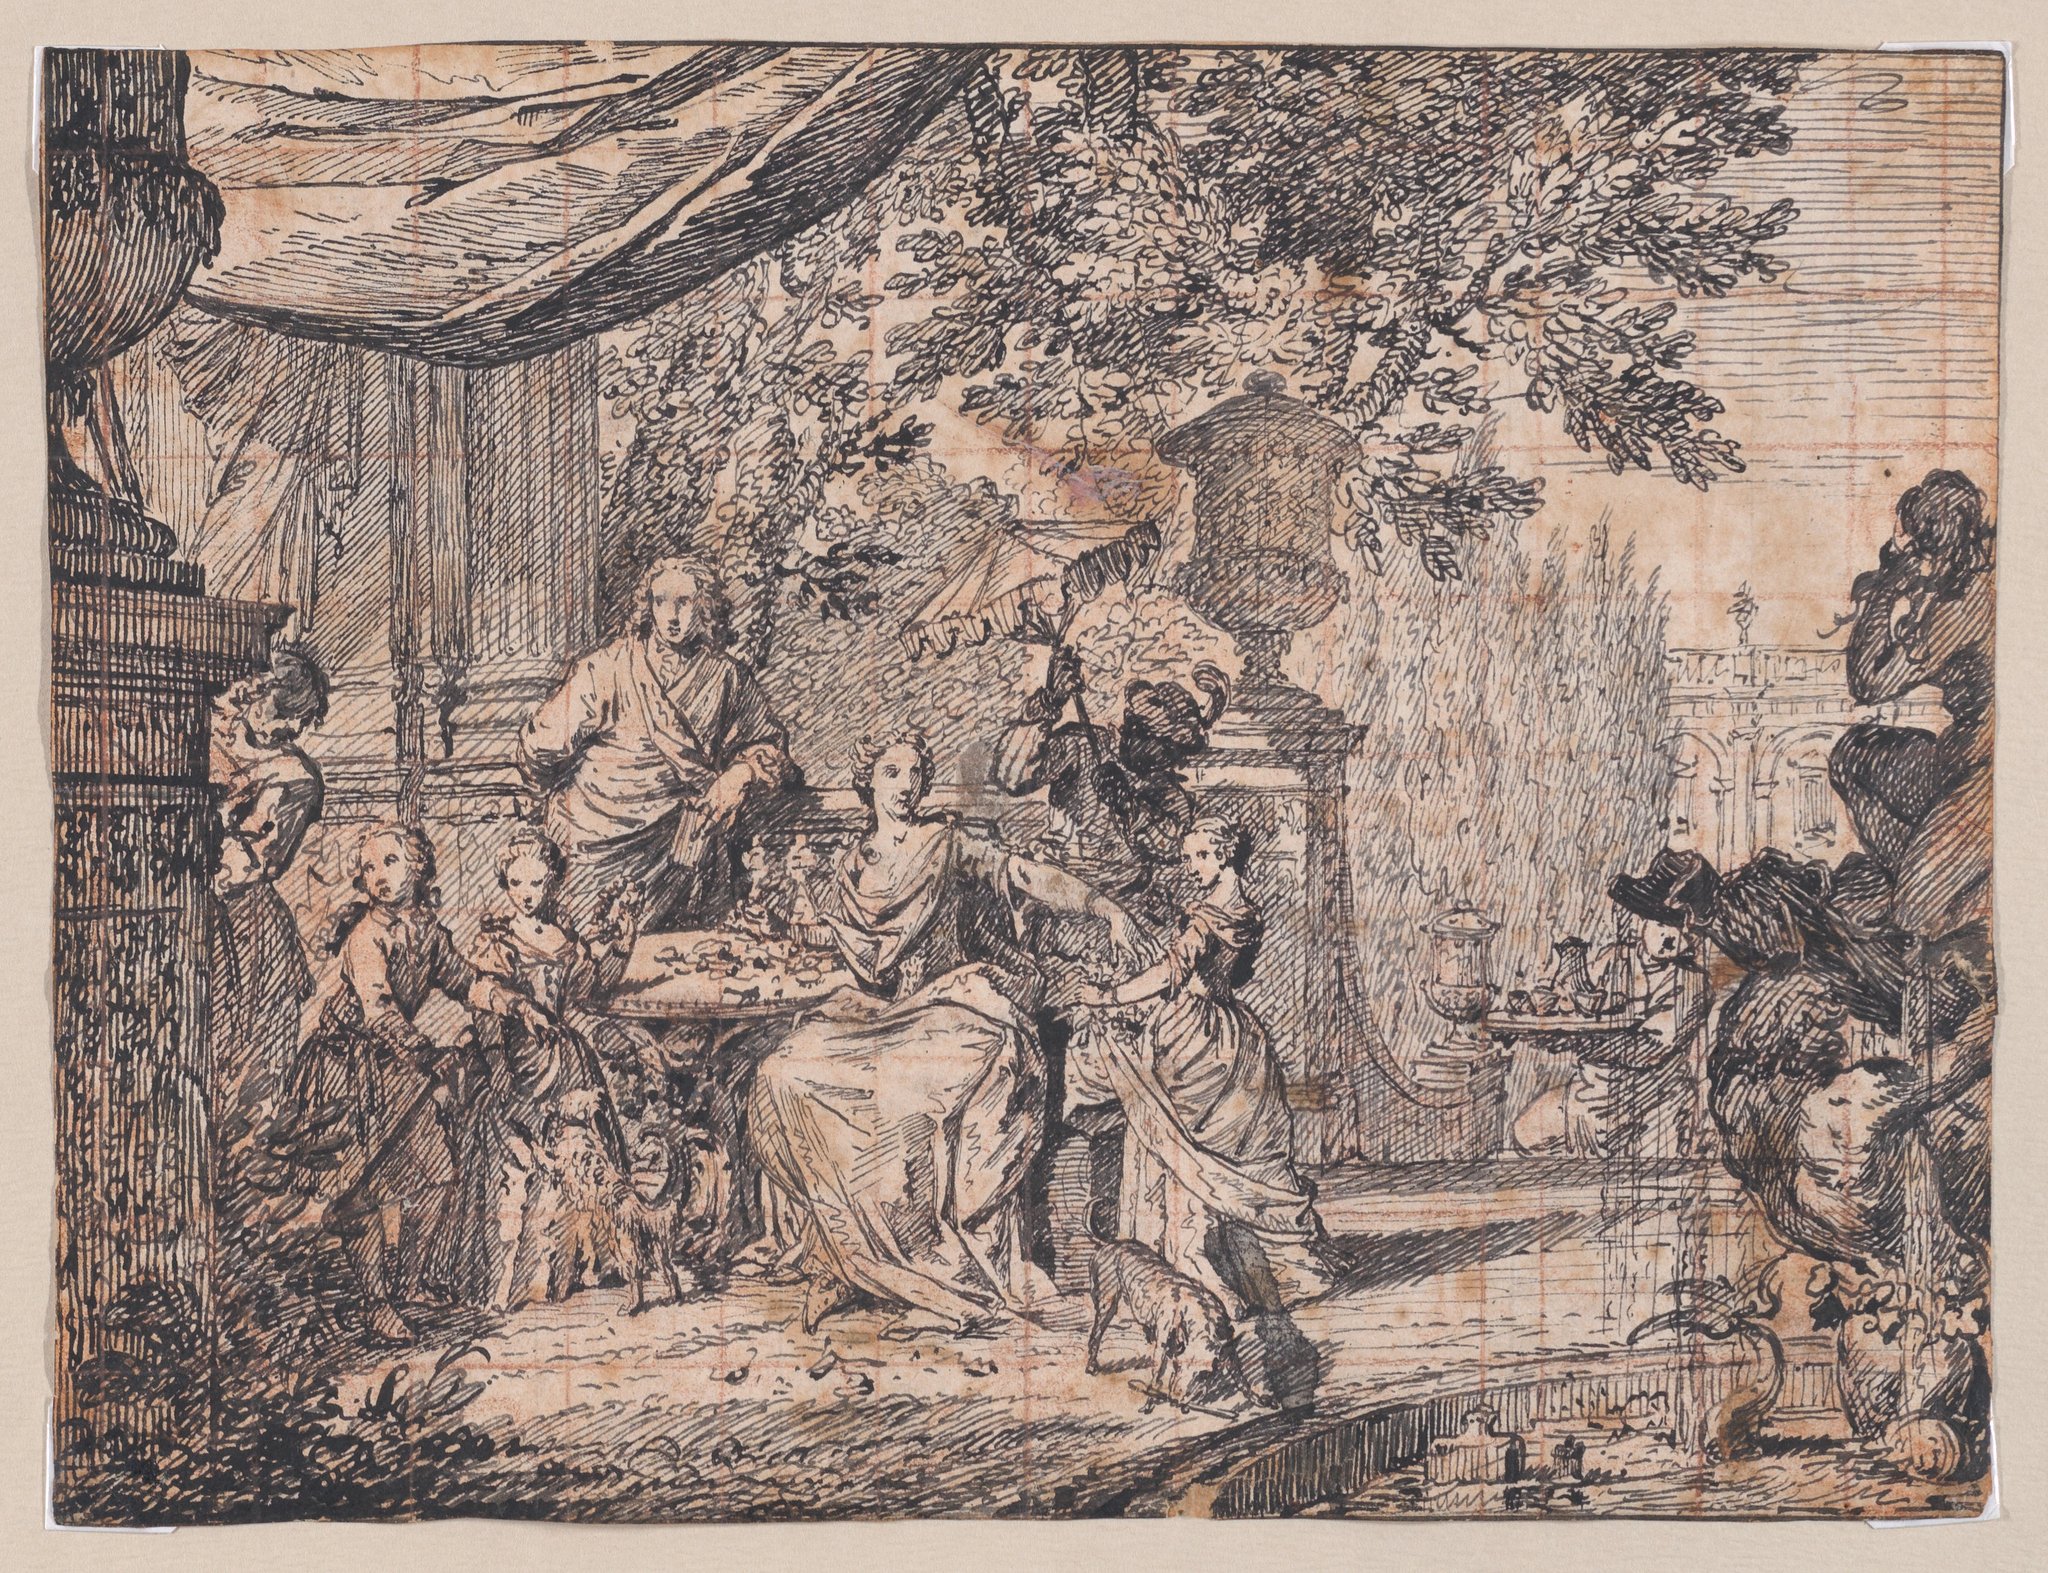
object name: drawing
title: A Family Gathering on a Terrace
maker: anonymous, french, 18th century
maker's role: artist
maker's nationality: french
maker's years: 1700-1800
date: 1700-1750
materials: chalk, ink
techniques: pen, drawing